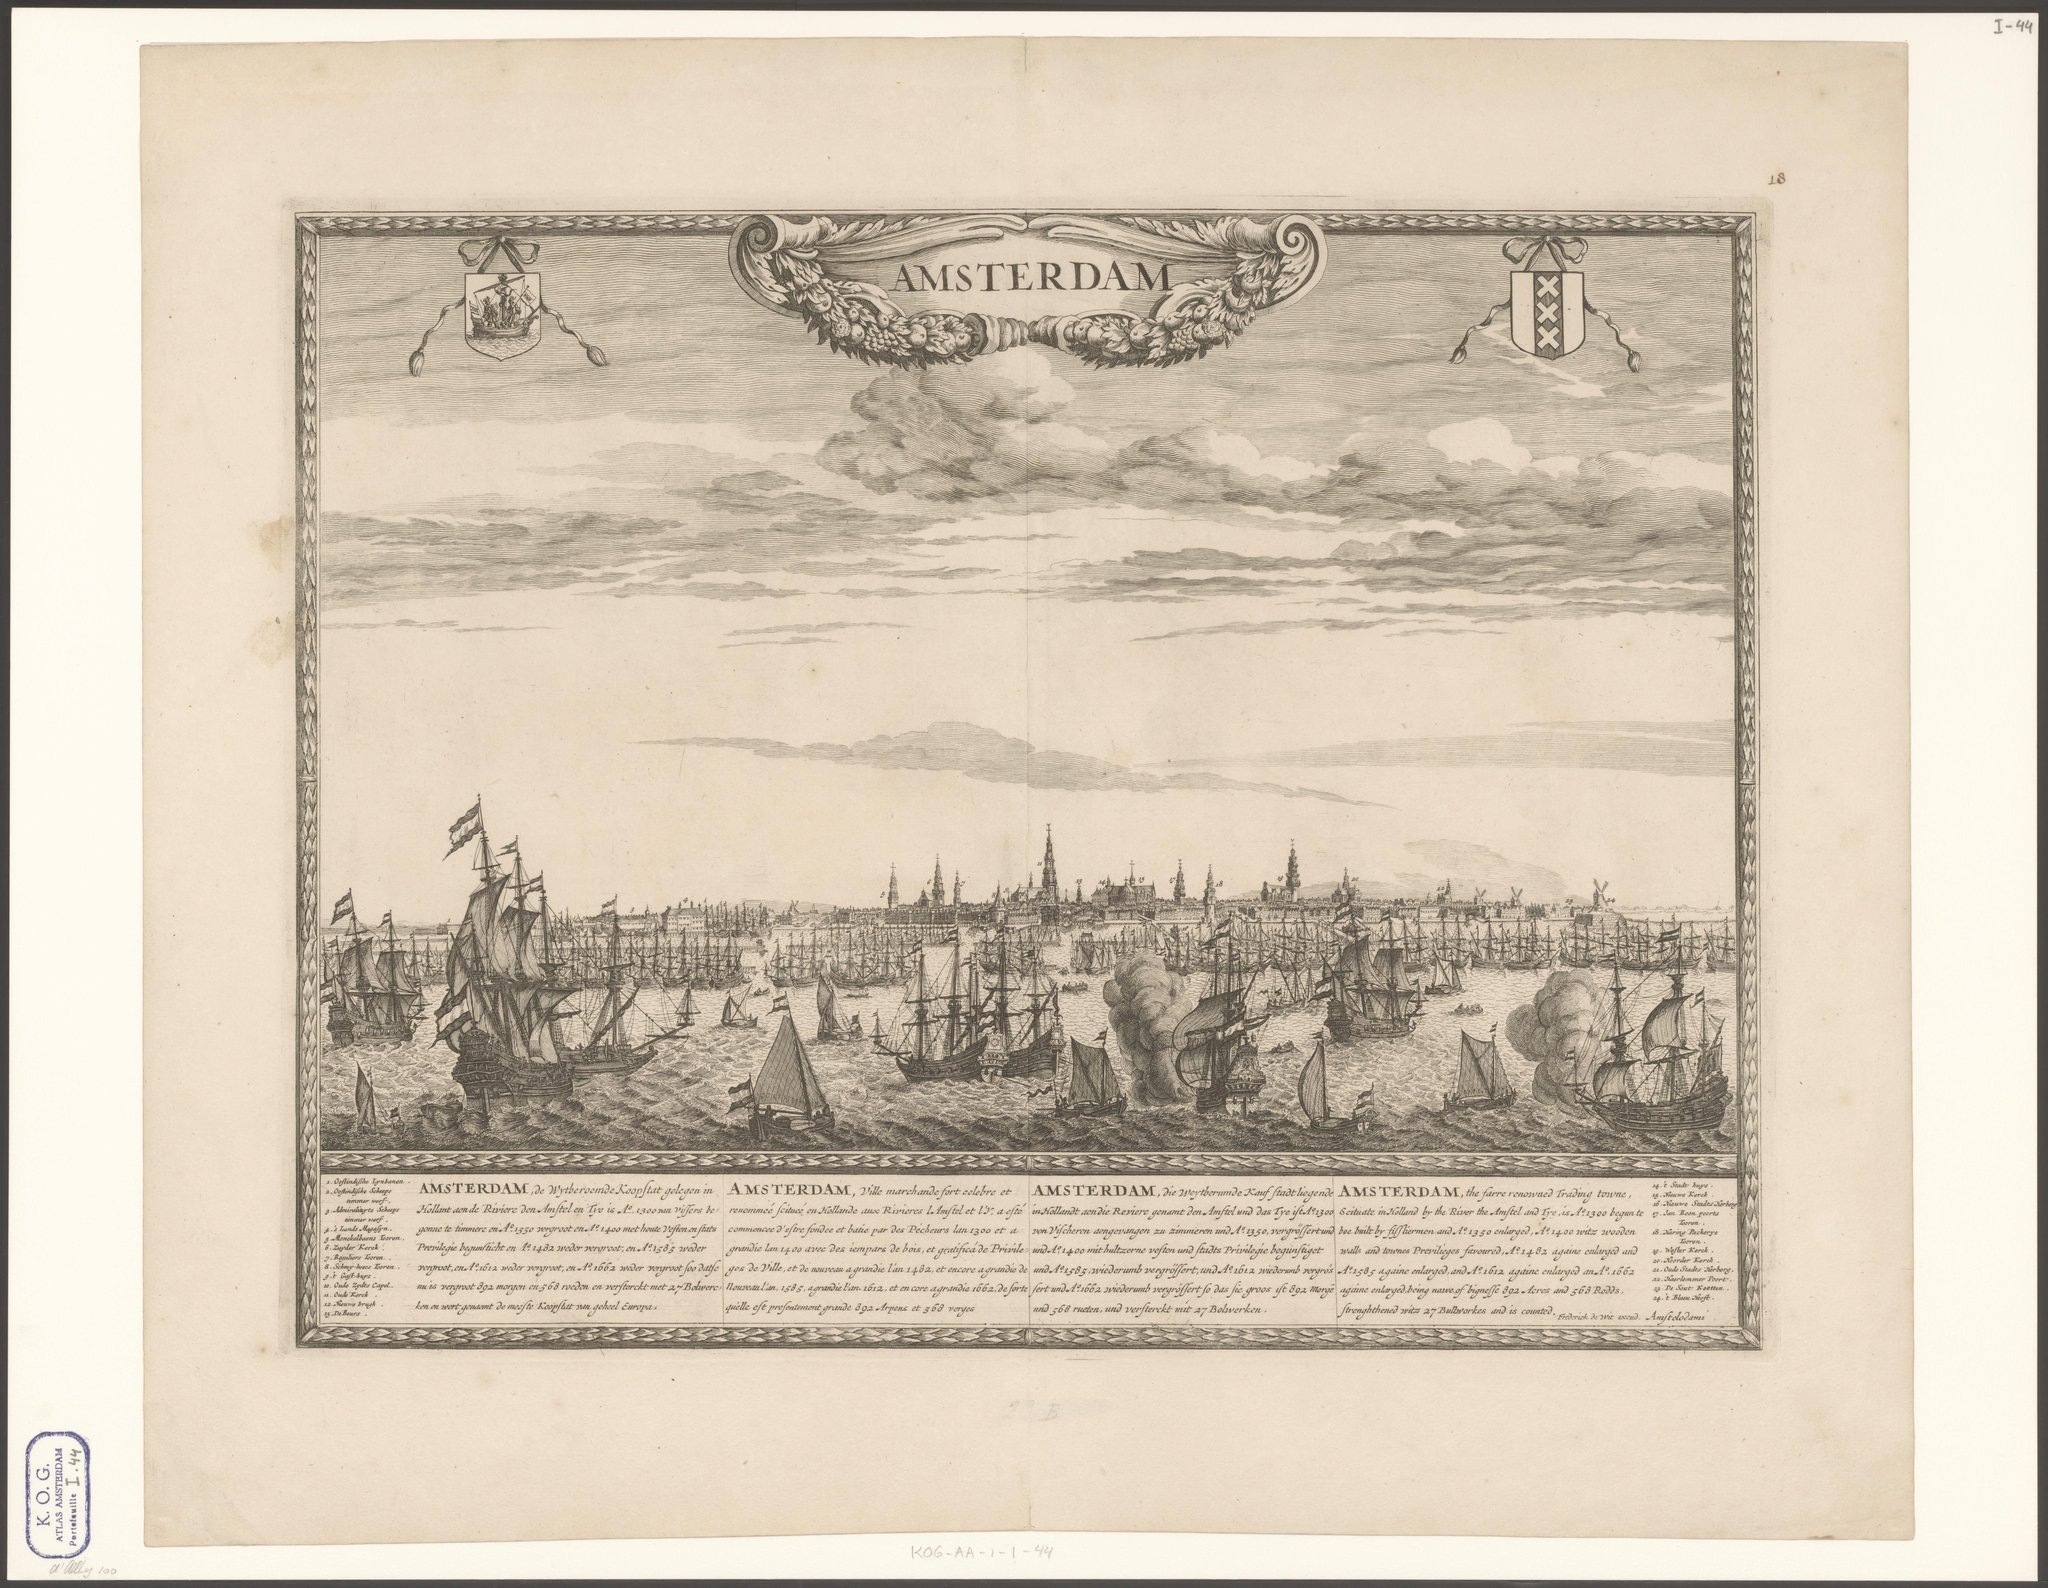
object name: print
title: Amsterdam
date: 1645-1706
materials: paper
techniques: engraving, etching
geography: amsterdam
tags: city-view in general; 'veduta', river, ships (in general) - cc - more than one ship, amsterdam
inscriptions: collector's mark: ‘I.44’ Lugt 1641b, number: ‘18’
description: Onderwerpsrubriek binnen de Atlas Amsterdam: Gezichten van den geheelen IJkant der Stad.